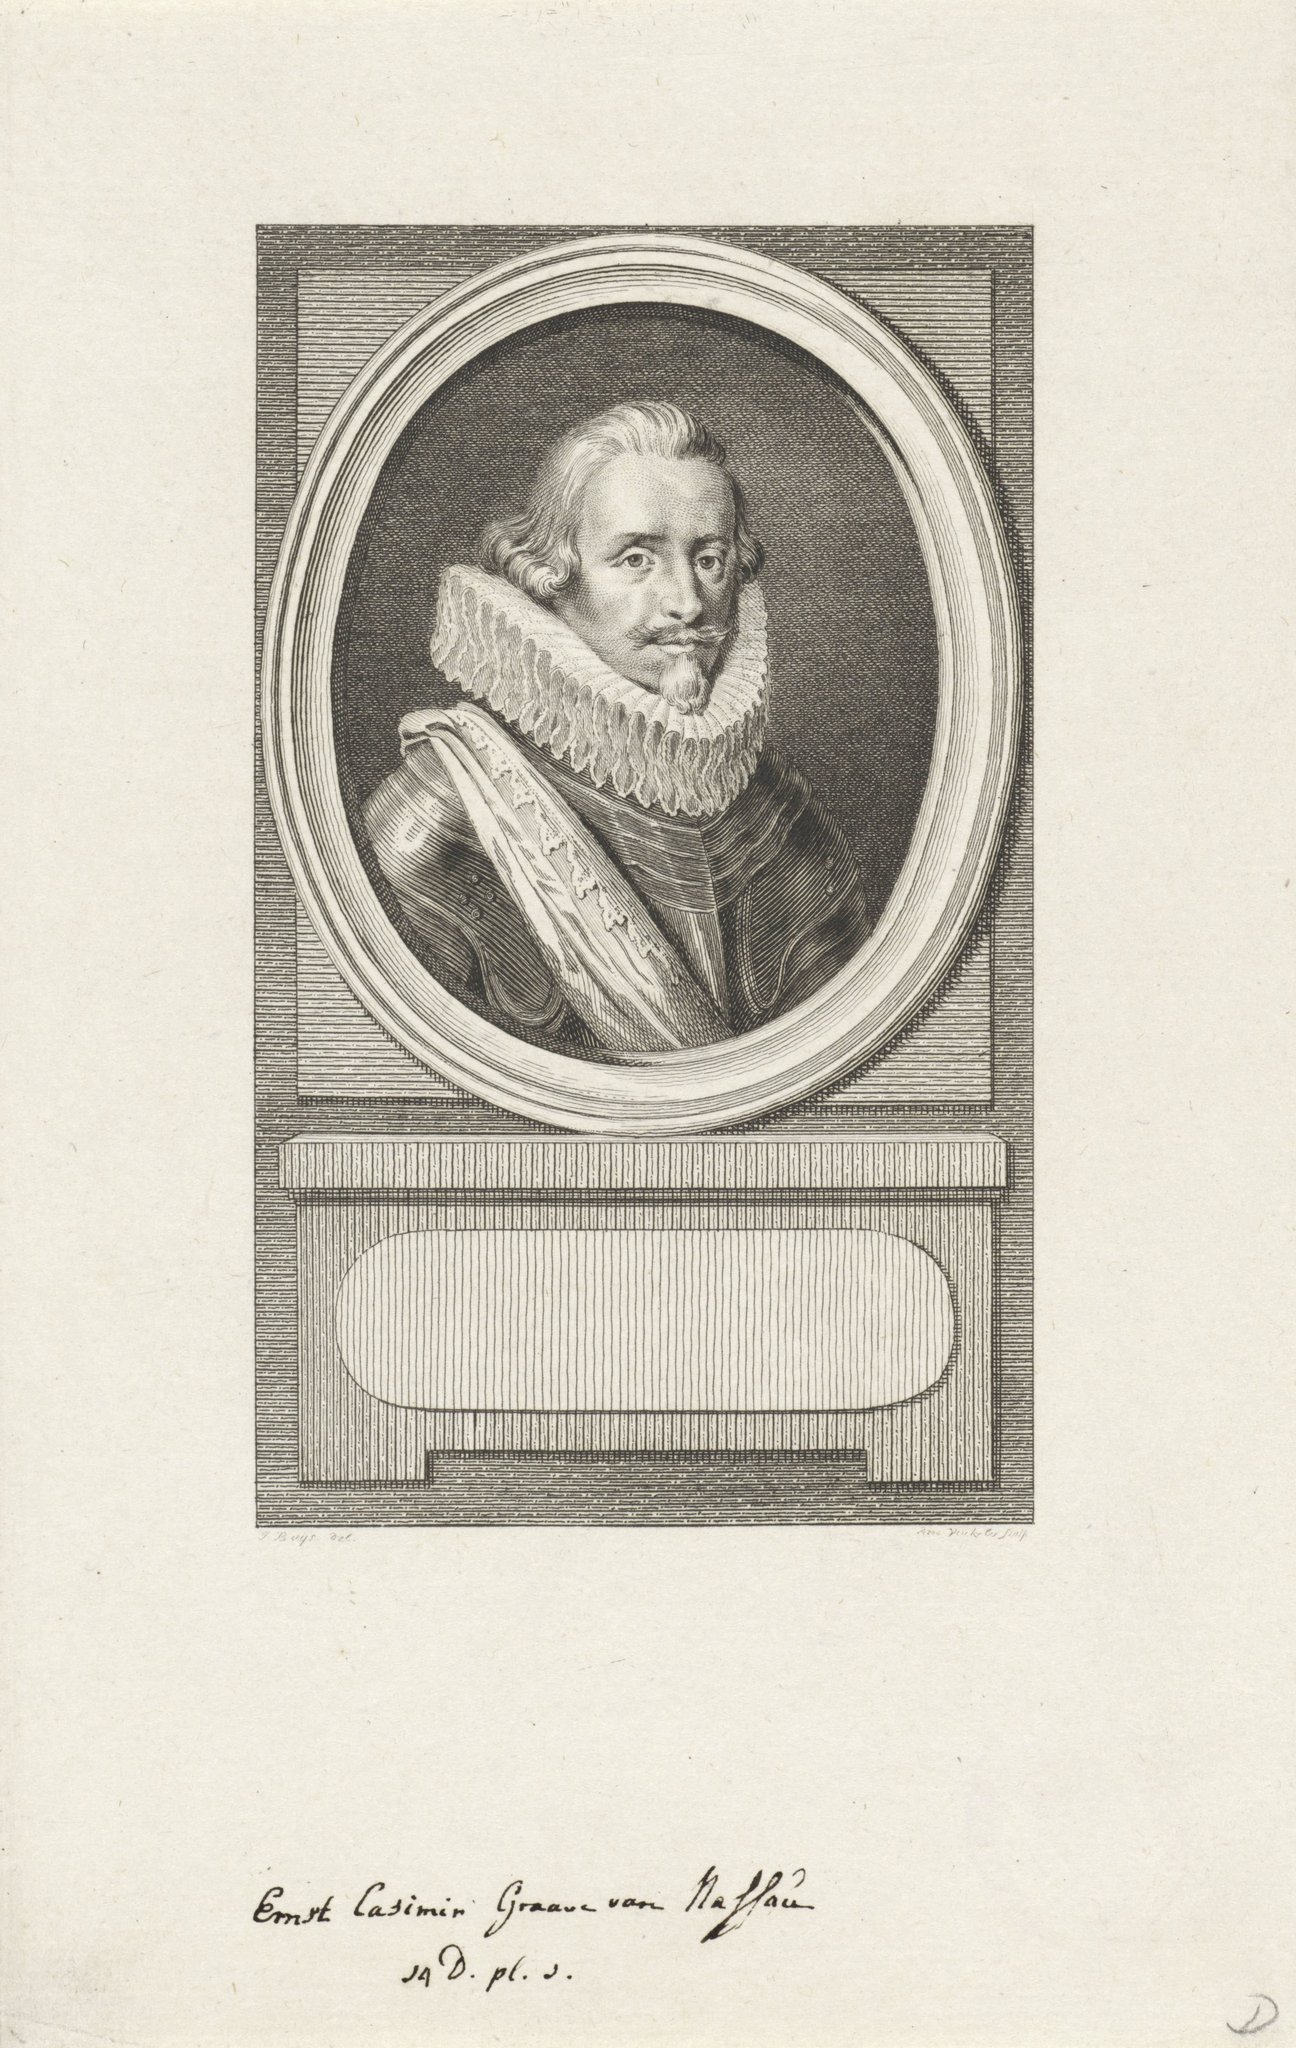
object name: print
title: Portret van Ernst Casimir, graaf van Nassau-Dietz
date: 1785-1796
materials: paper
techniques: etching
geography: amsterdam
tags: ernst casimir graaf van nassau-dietz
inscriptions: collector's mark: Lugt 240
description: Latere staat prent gebruikt als boekillustratie in: Kok, Jacobus. Vaderlandsch woordenboek : met kaarten, plaaten en pourtraitten. Amsterdam: Johannes Allart, 1785-1796. Deel XIV.